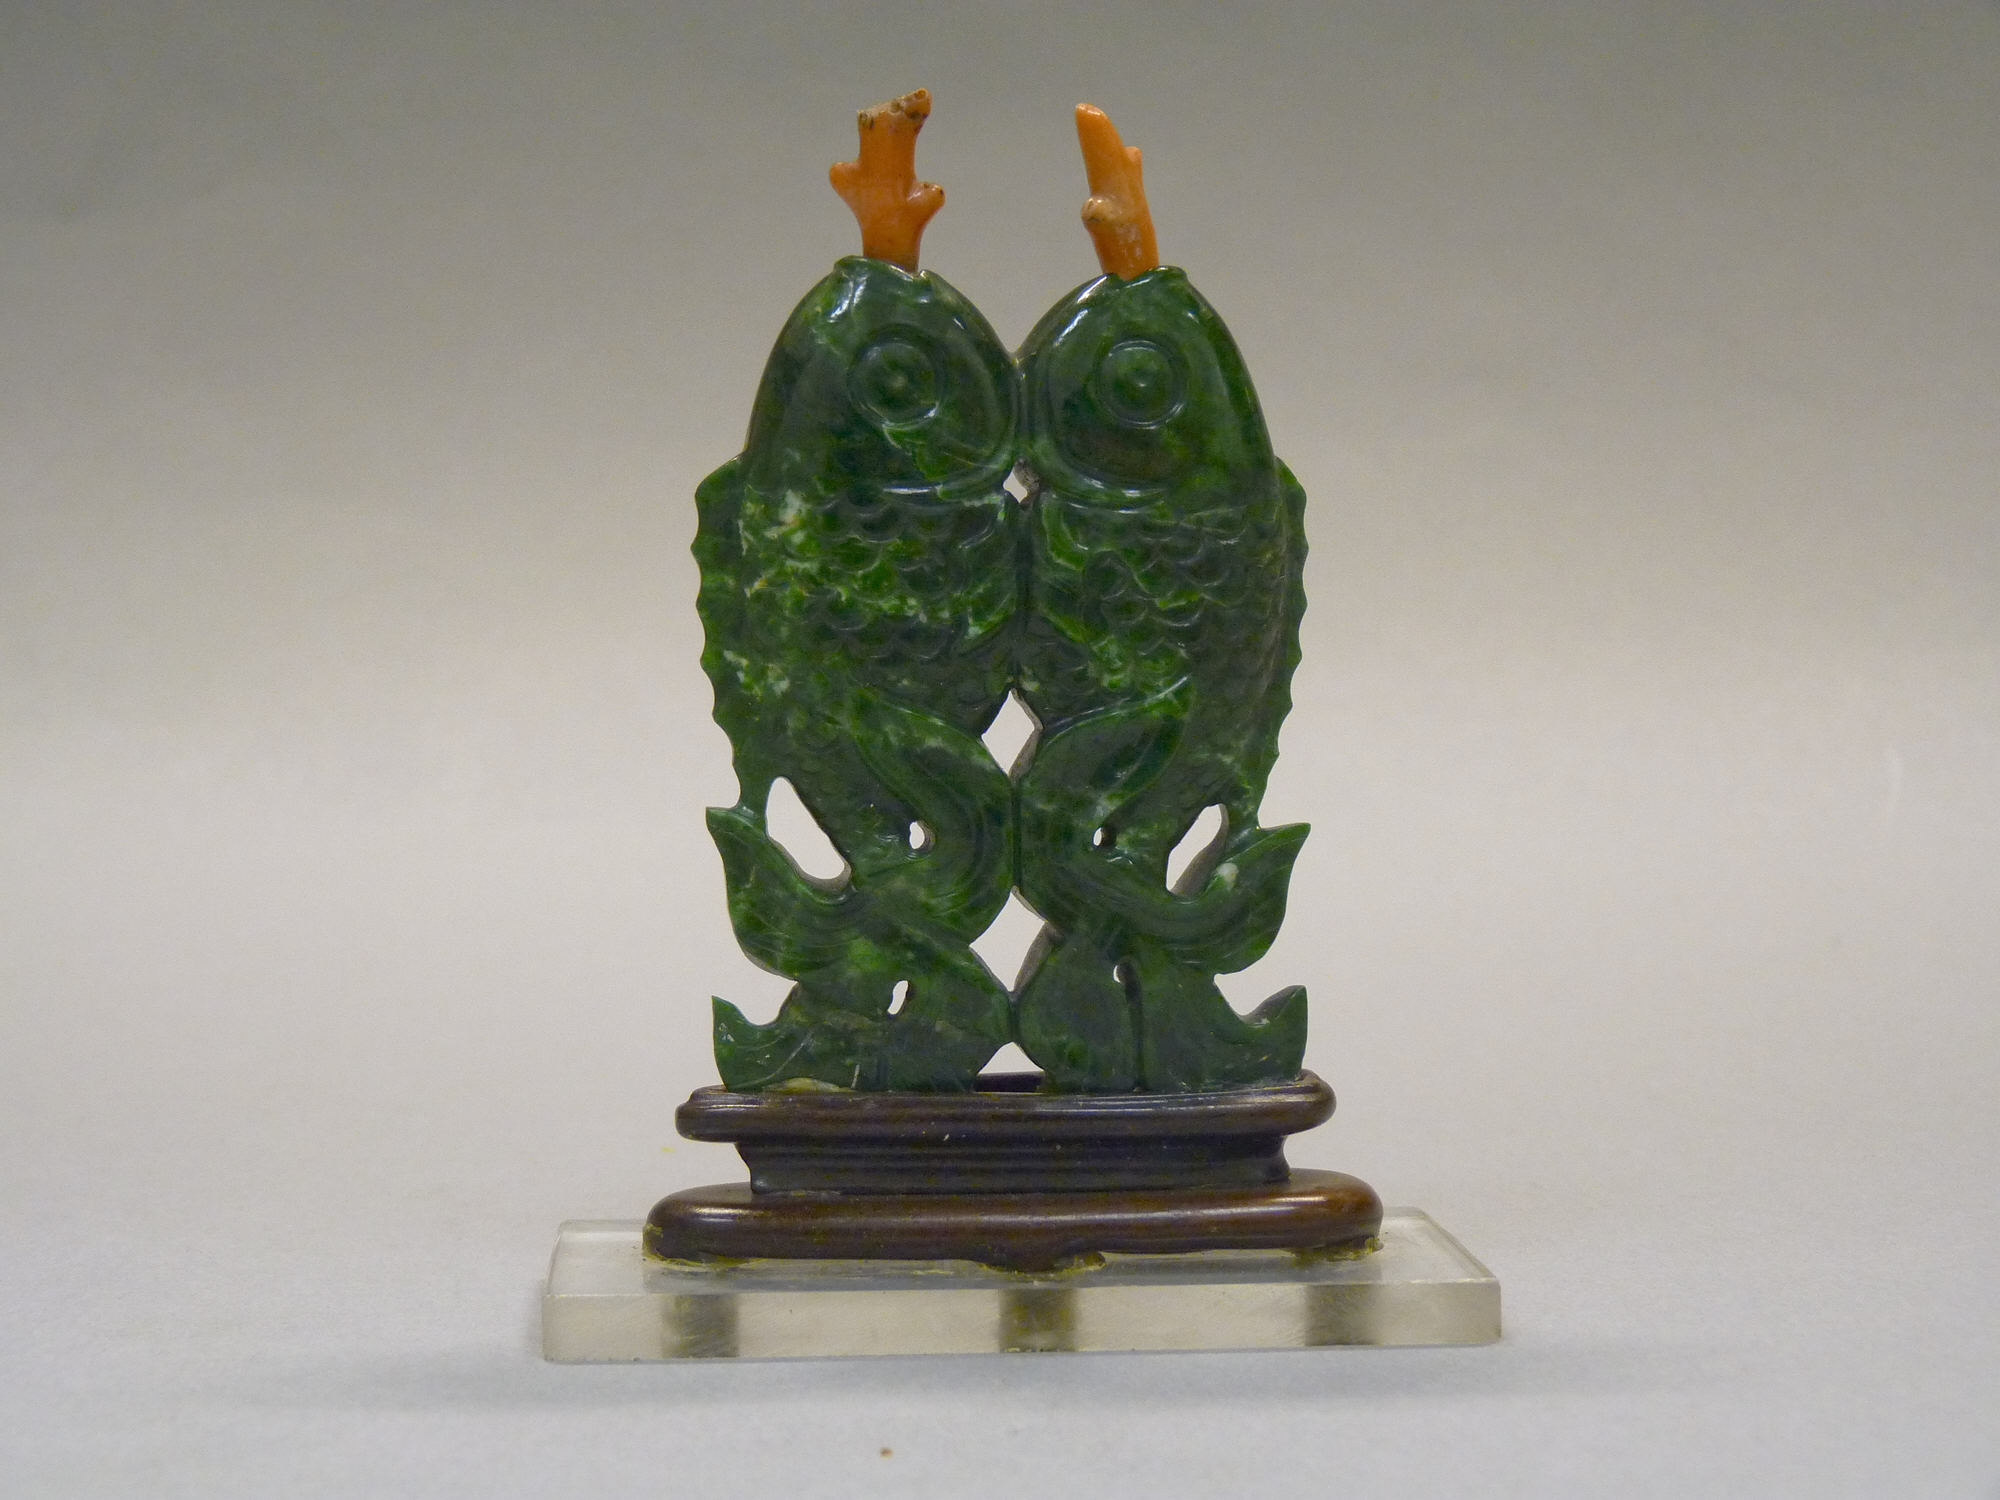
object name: double snuff bottle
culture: chinese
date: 1801-1900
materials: coral, jade, wood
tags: fish